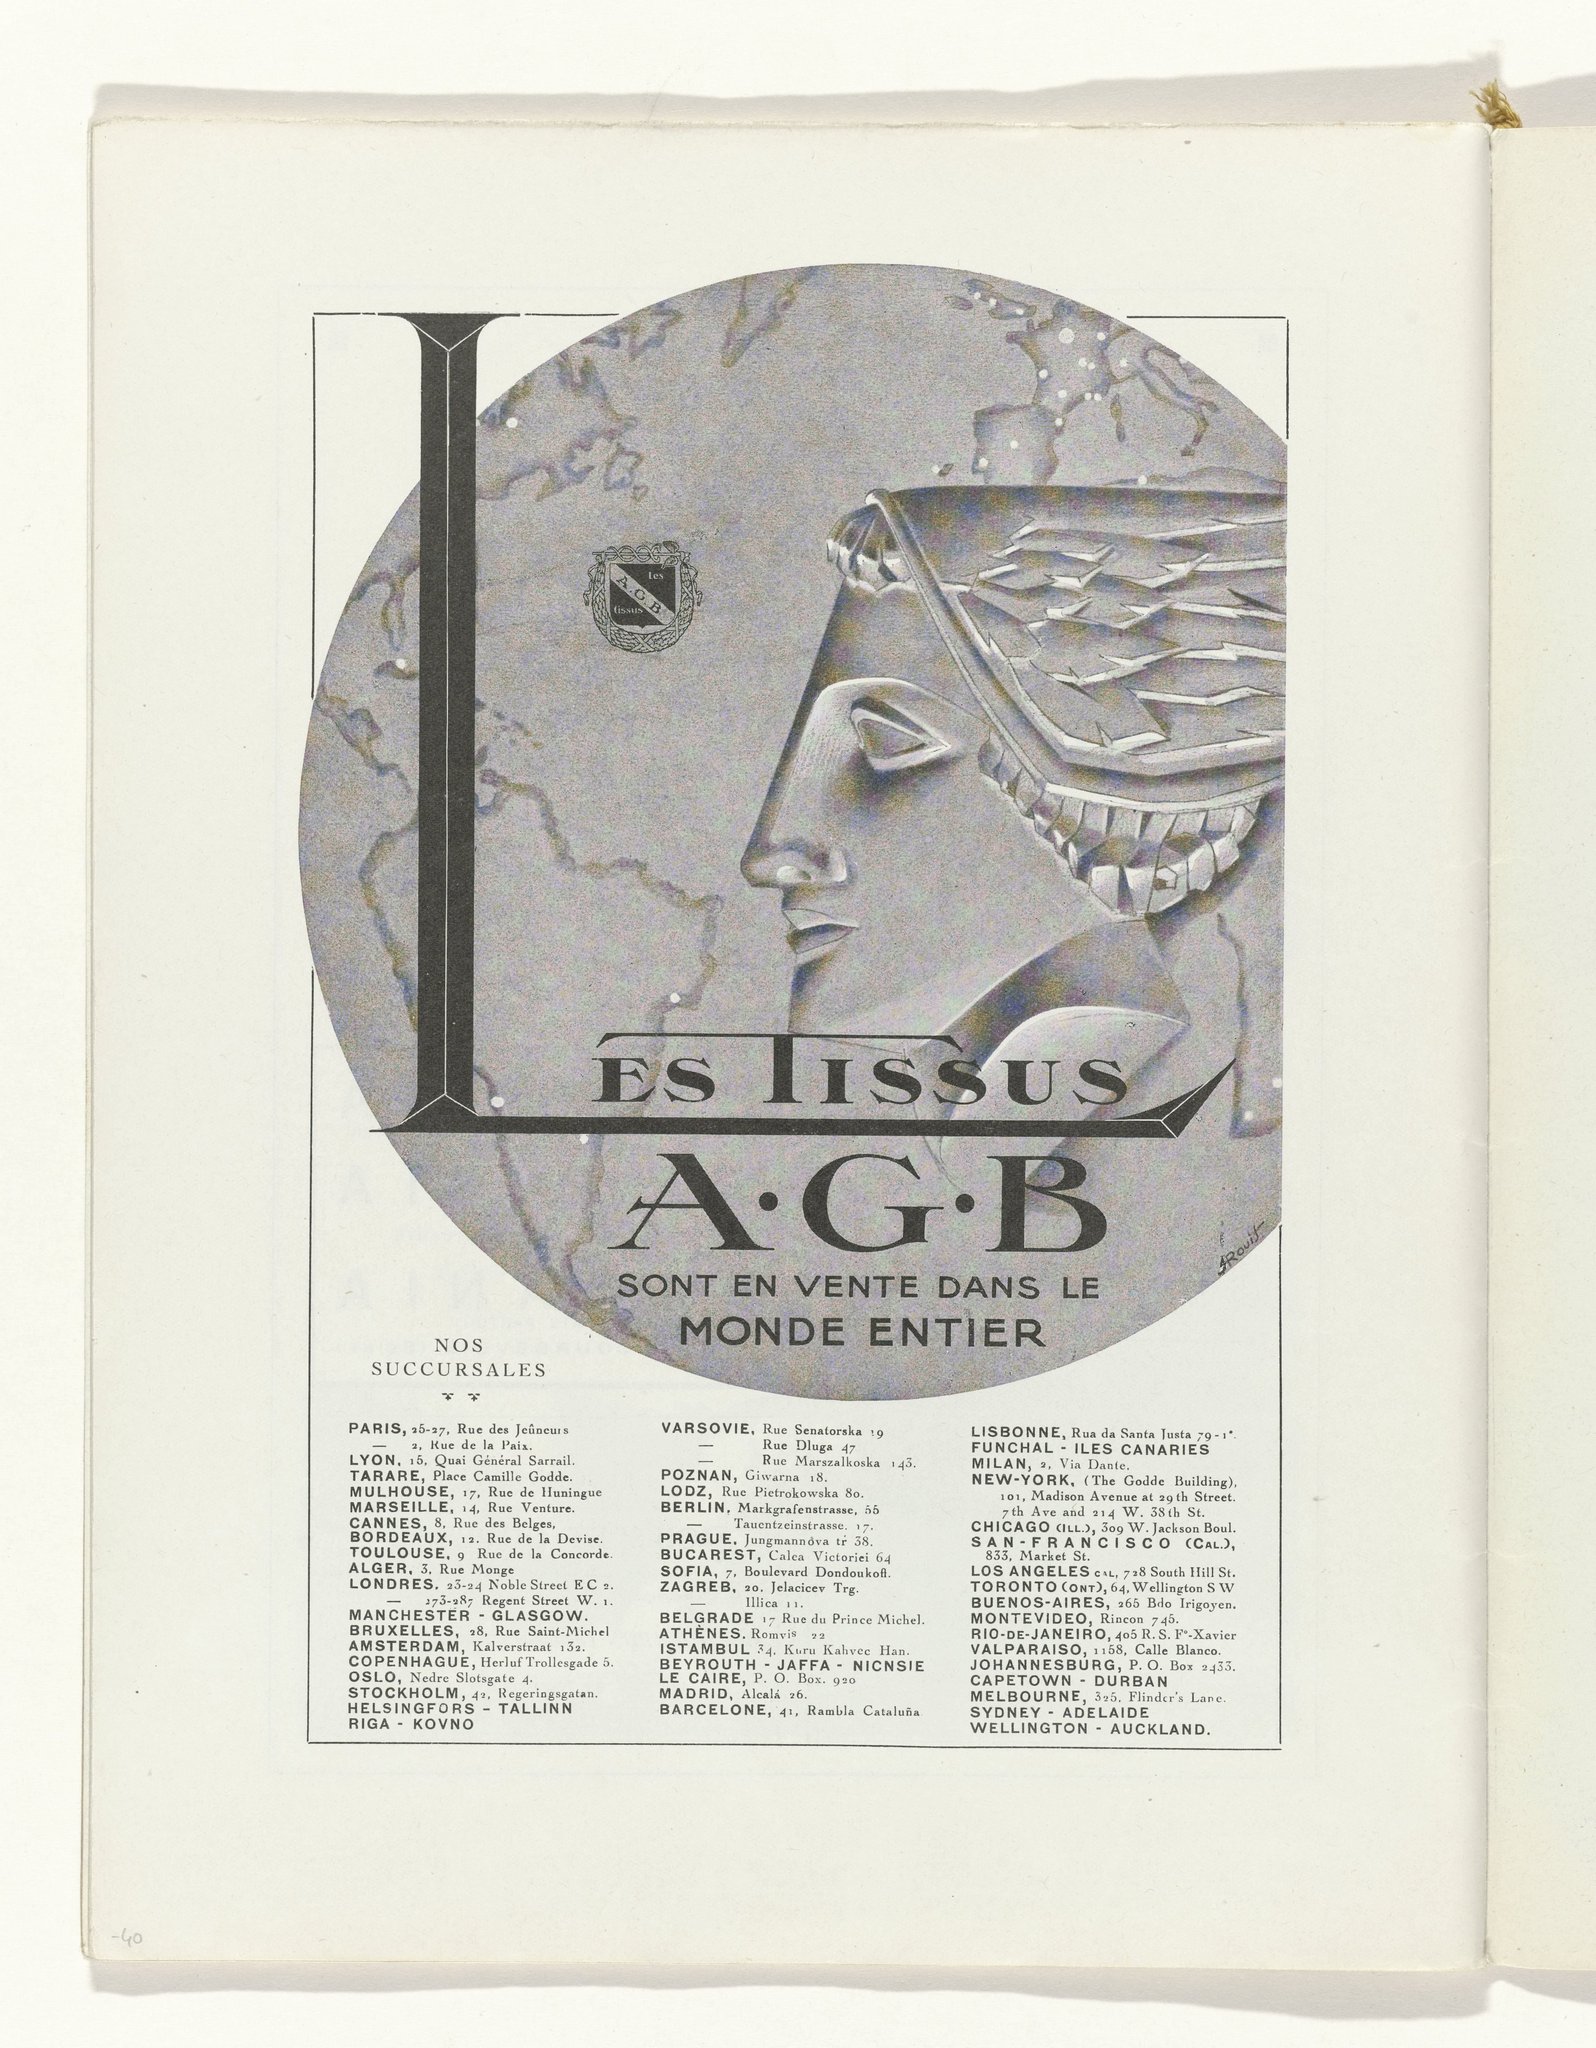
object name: magazine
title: Art - Goût - Beauté, Feuillets de l' élégance féminine, Juin 1932, No. 142, 12e Année, p. 40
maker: henri rouit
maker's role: publisher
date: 1932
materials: paper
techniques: photography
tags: fashion plates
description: Advertentie voor ´Les Tissus A.G.B.´. Pagina uit het modetijdschrift Art-Goût-Beauté (1920-1933).